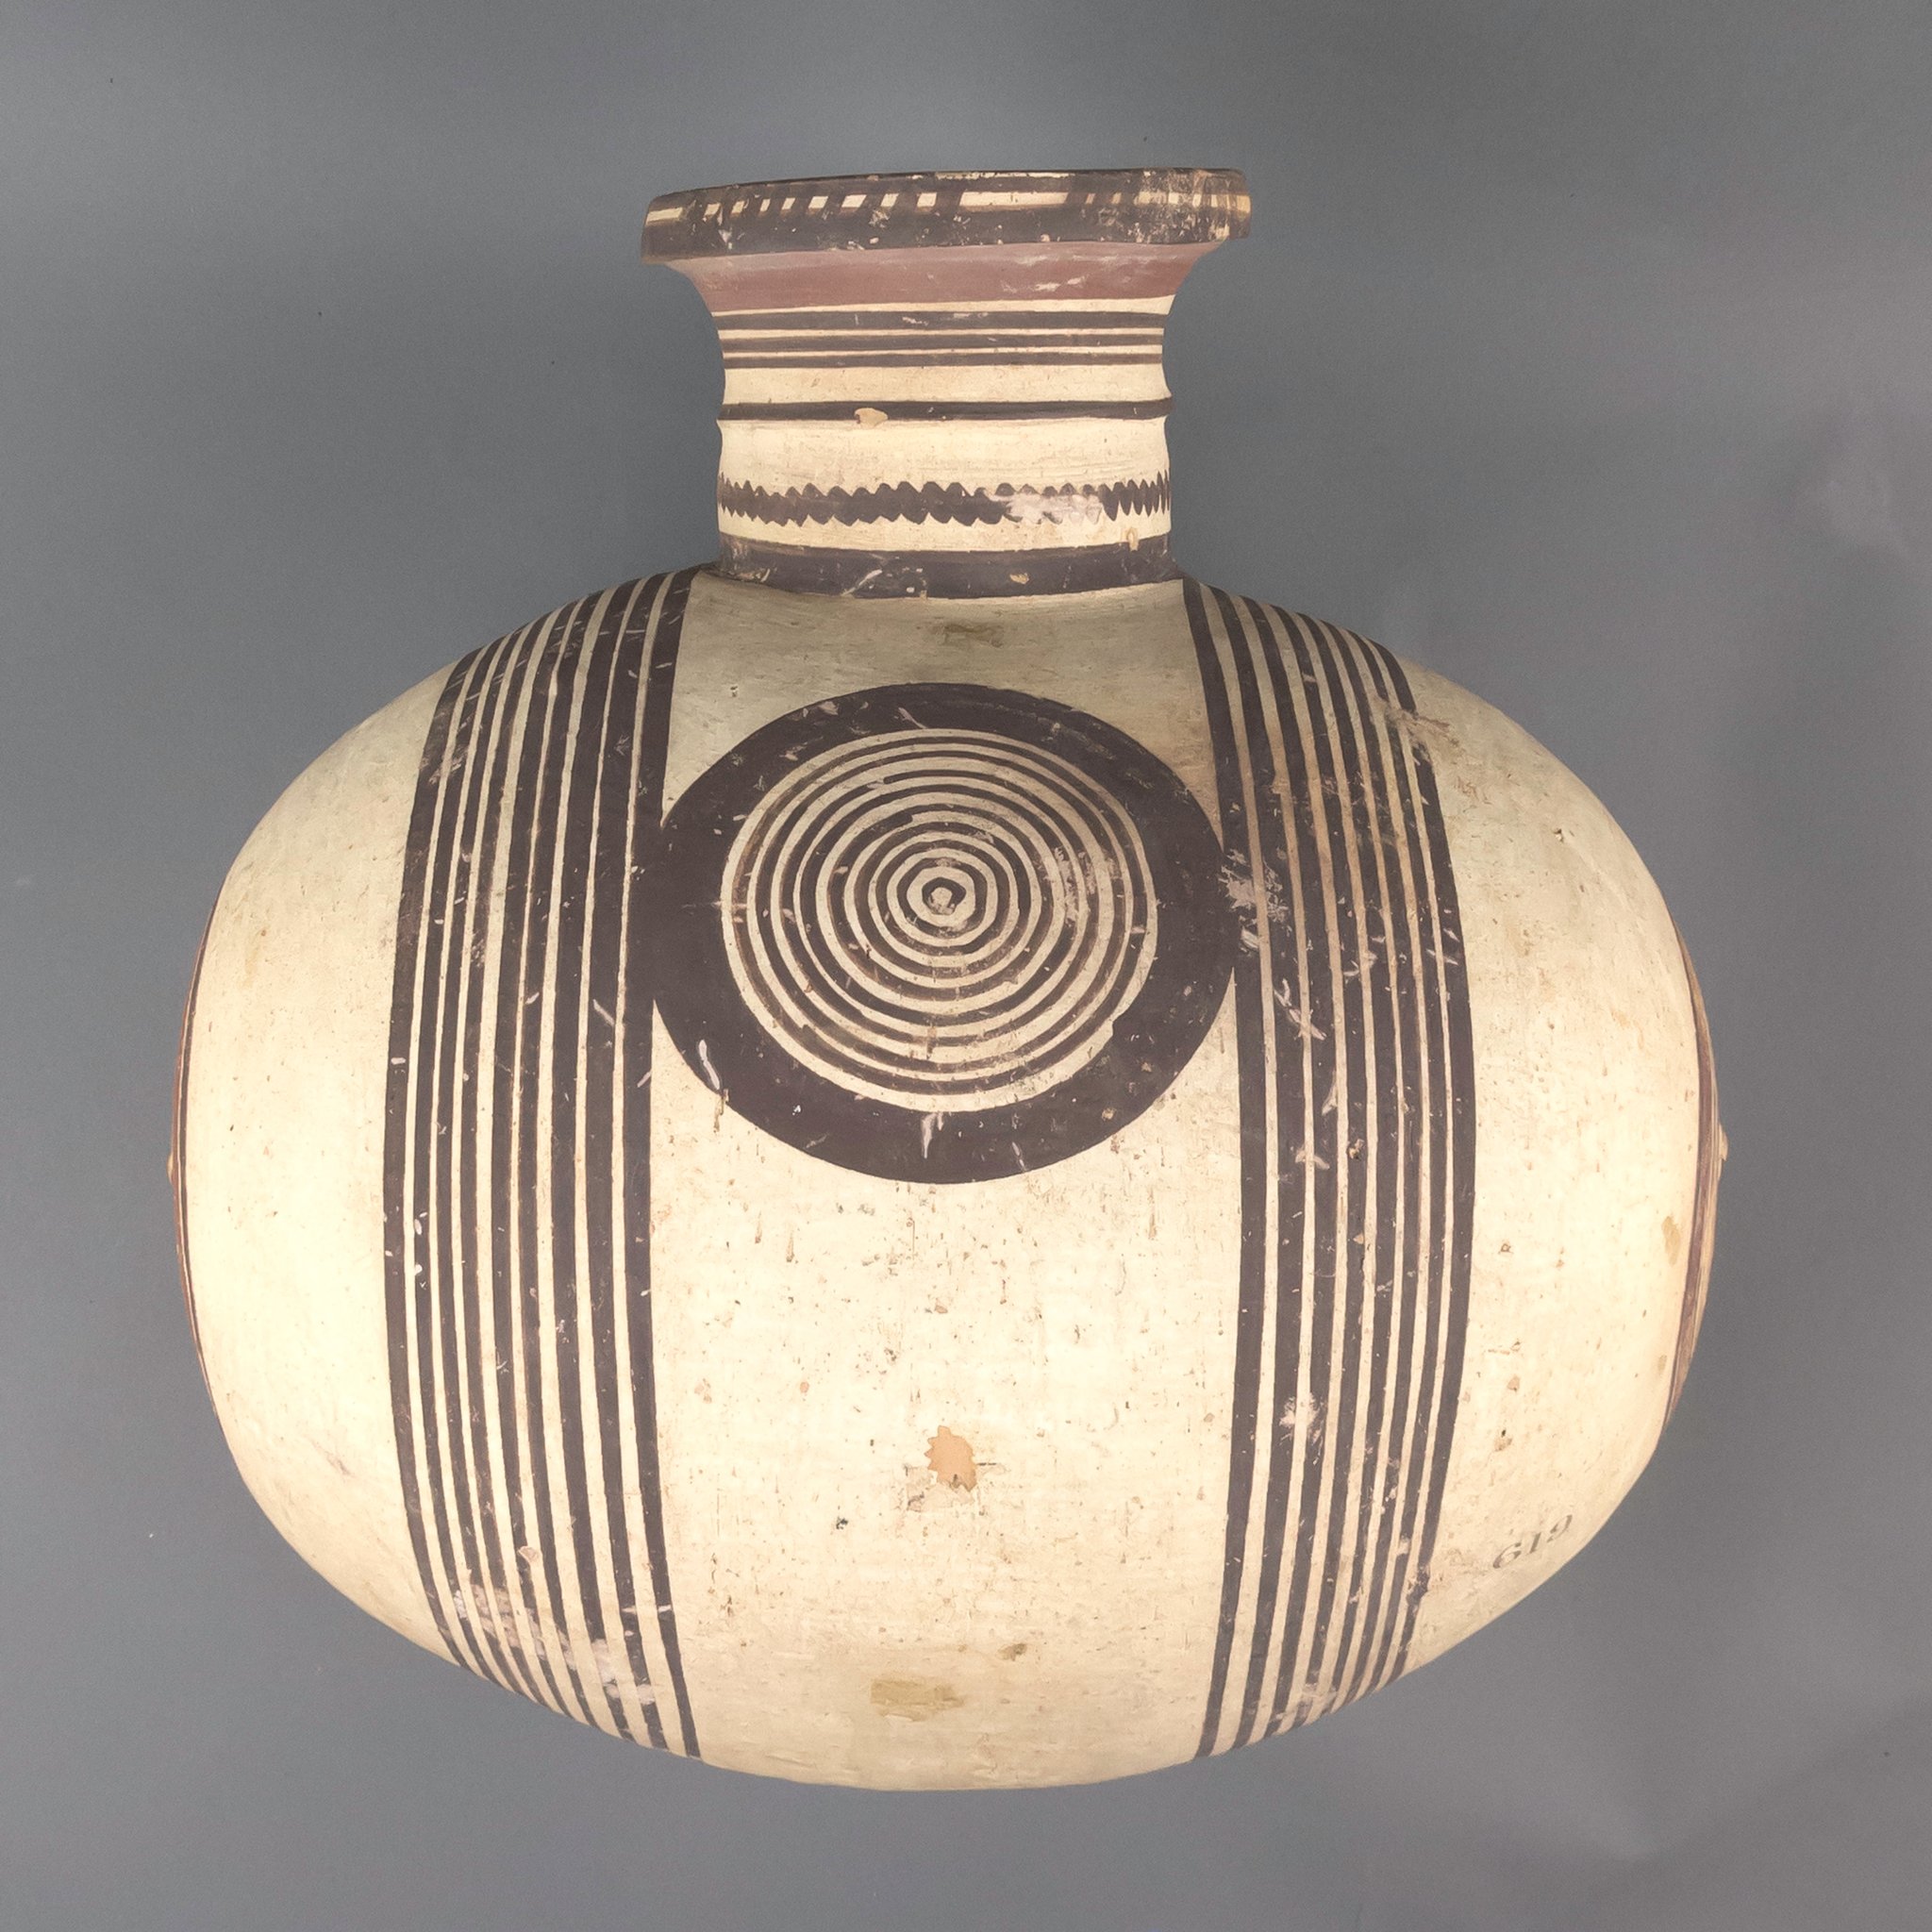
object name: jug, barrel shaped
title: Jug, barrel-shaped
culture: cypriot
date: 750-600 BCE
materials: terracotta